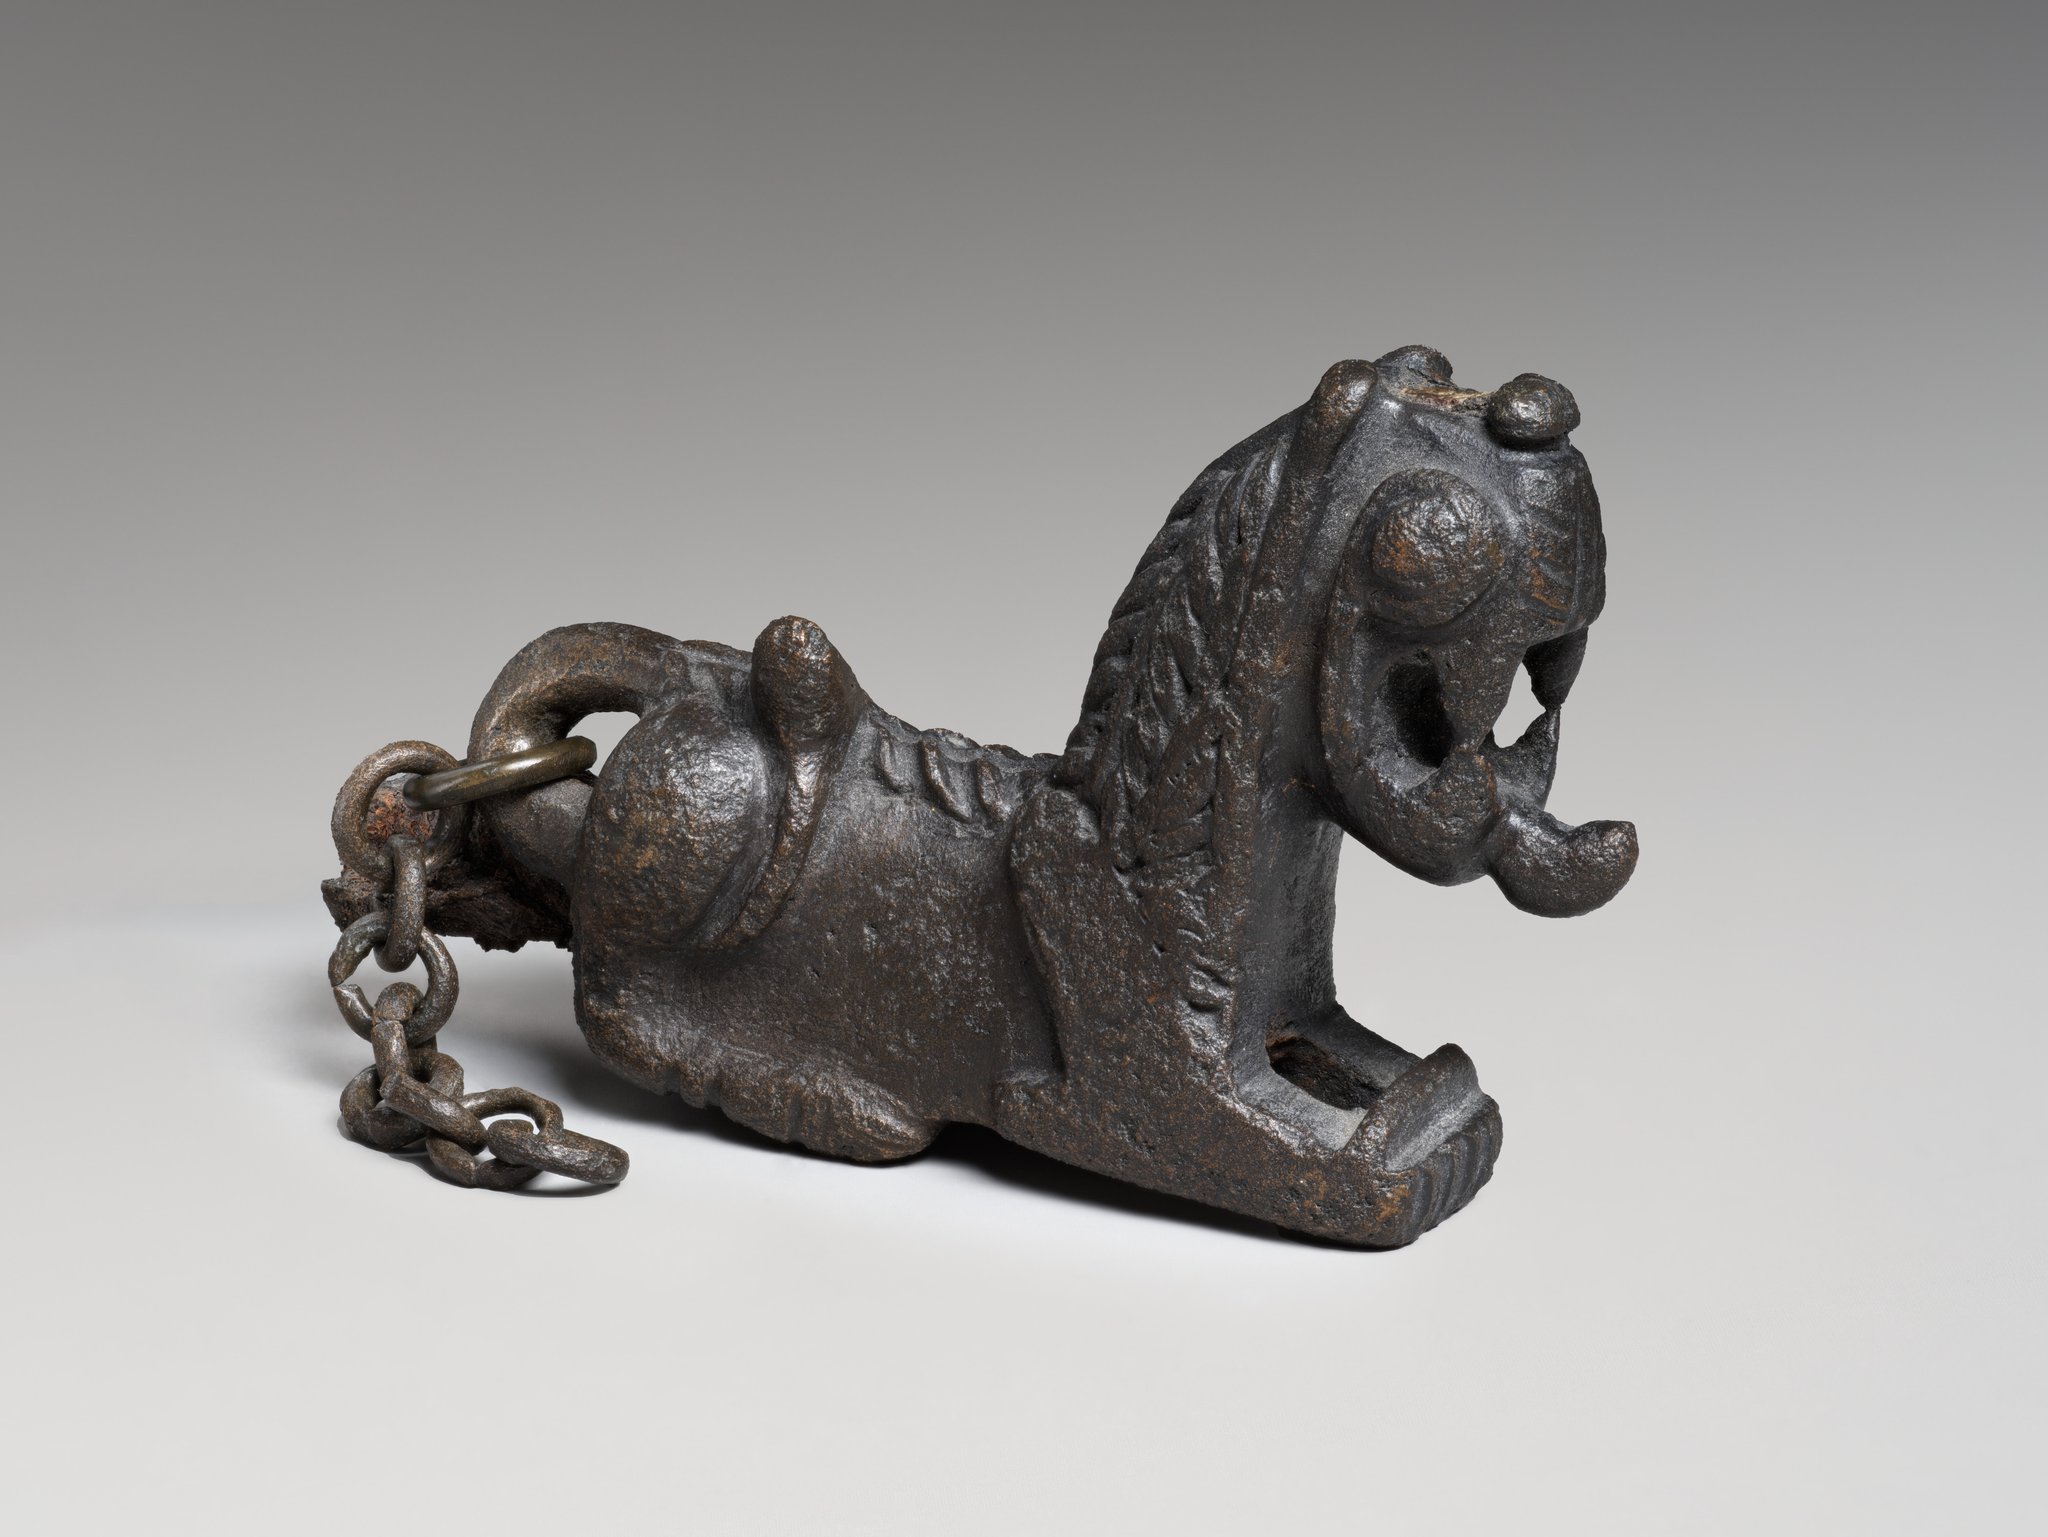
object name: pin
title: Pin in the form of a lion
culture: iranian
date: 900-801 BCE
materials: bronze, iron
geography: iran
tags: lions